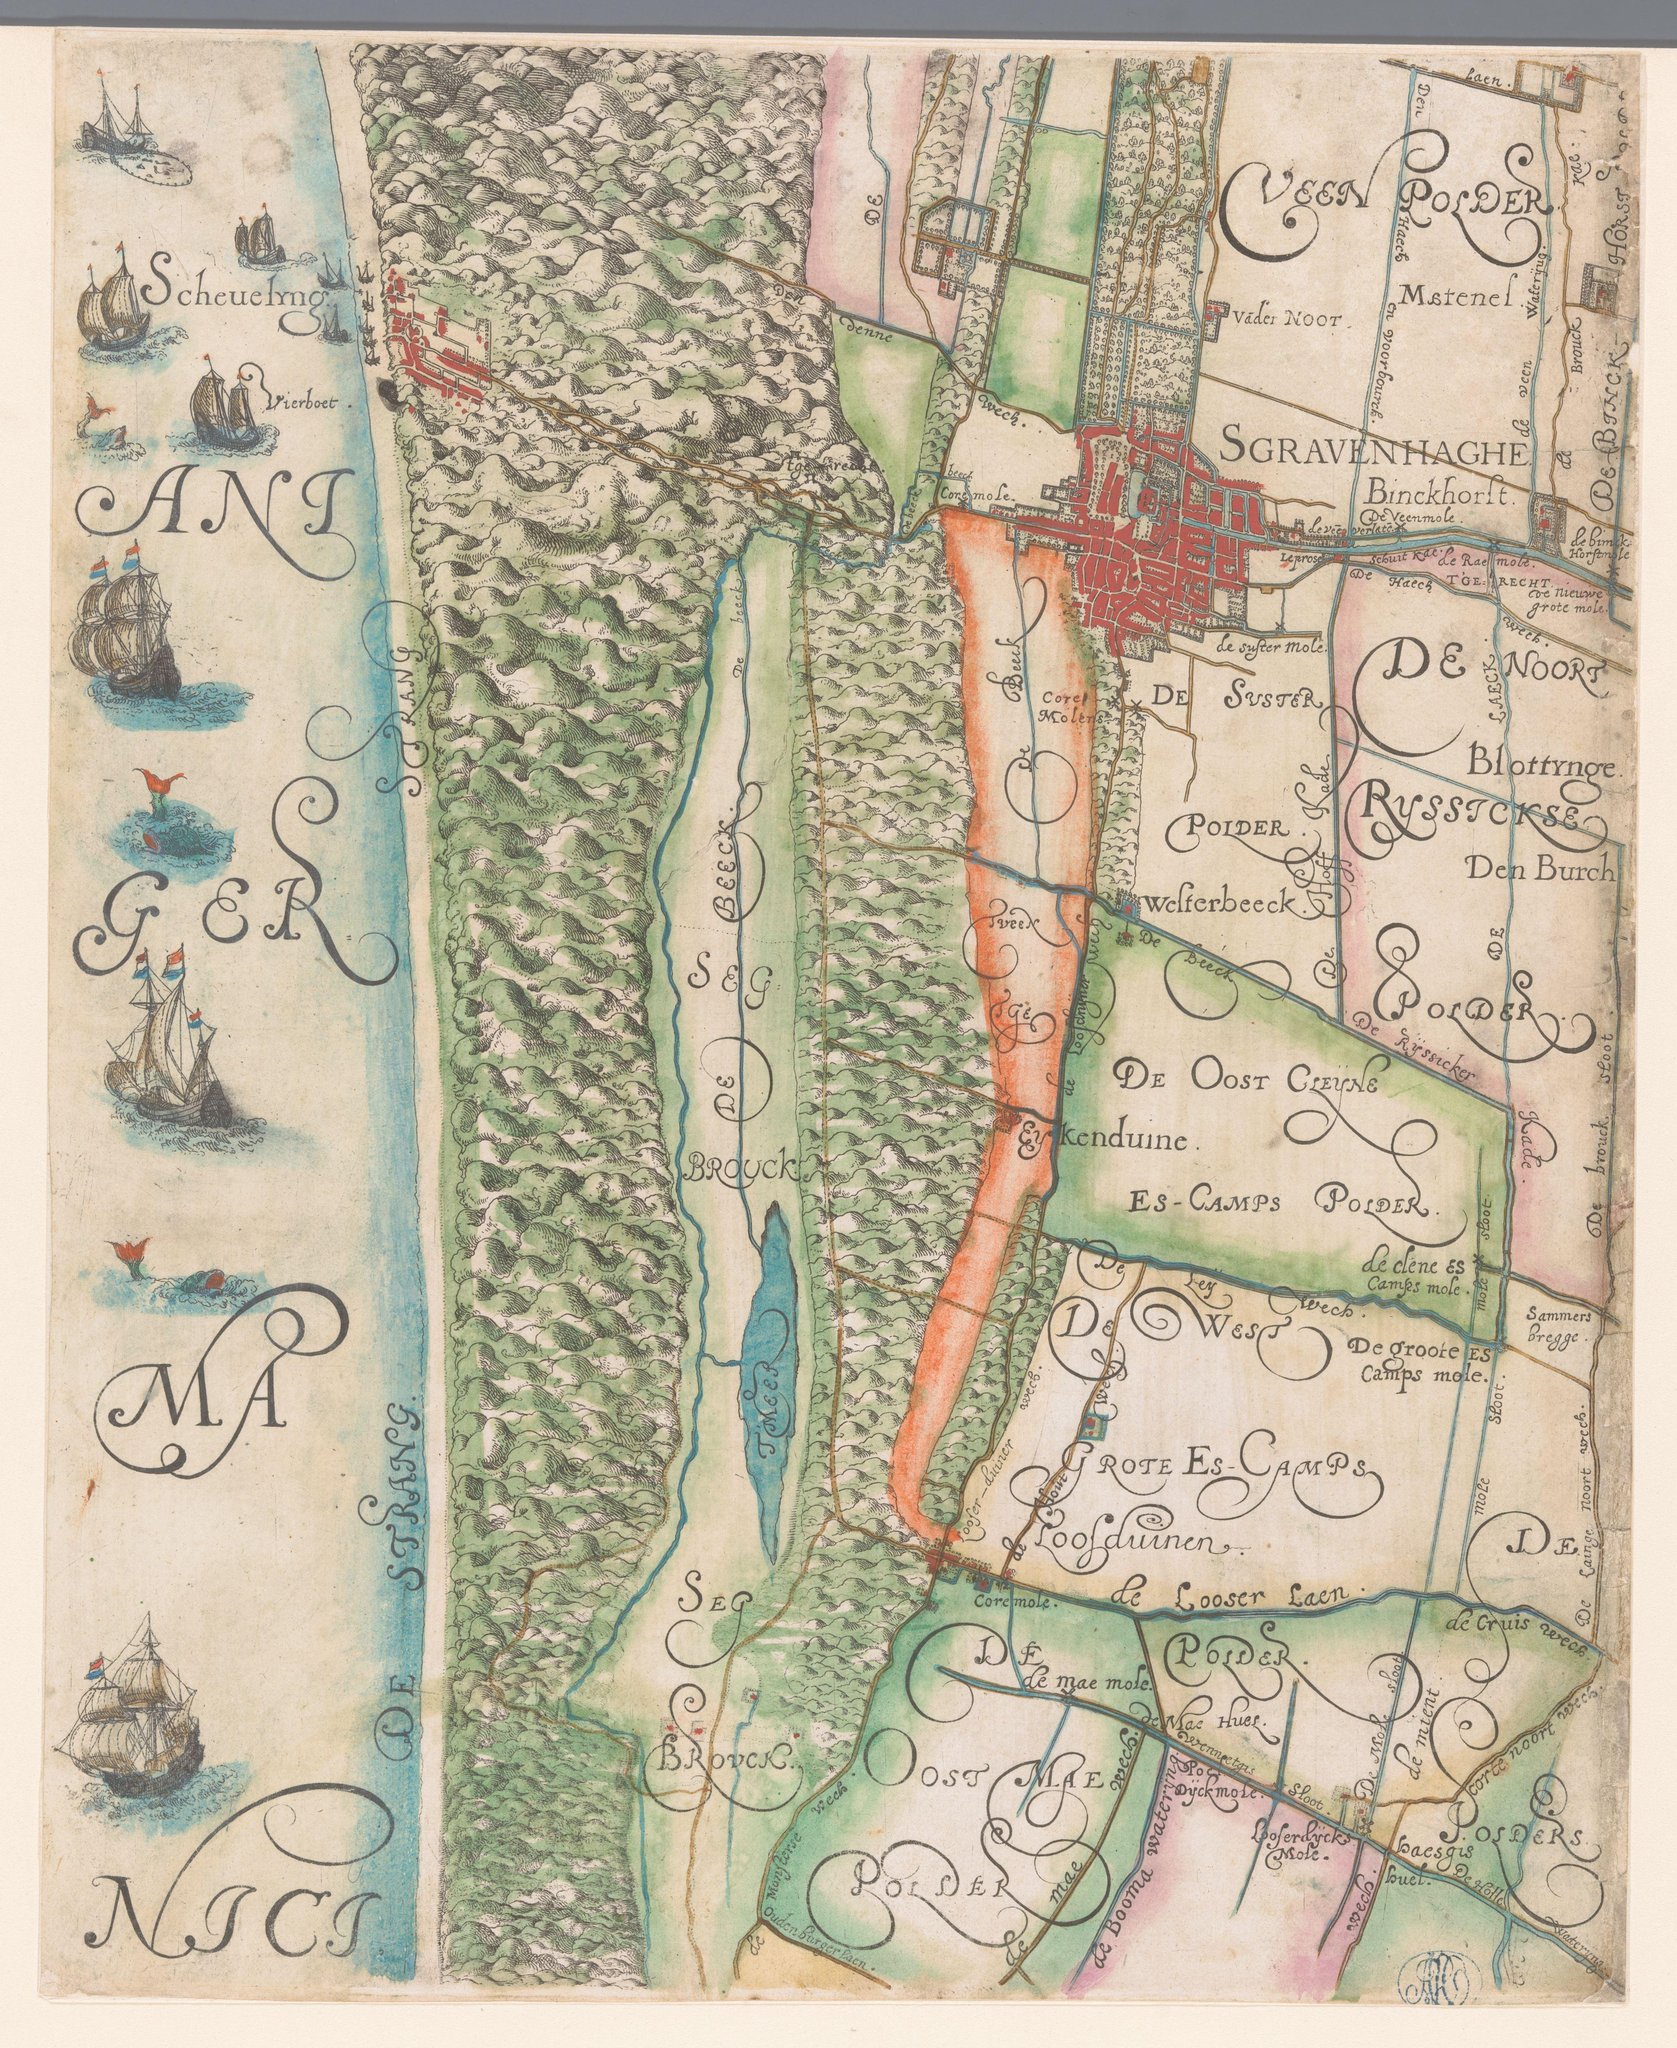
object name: map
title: Kaart van het Hoogheemraadschap van Delfland, met Den Haag en omgeving, deel links midden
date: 1611-1692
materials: paper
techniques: engraving, etching, hand coloring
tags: maps of separate countries or regions, the hague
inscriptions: collector's mark: Lugt 195